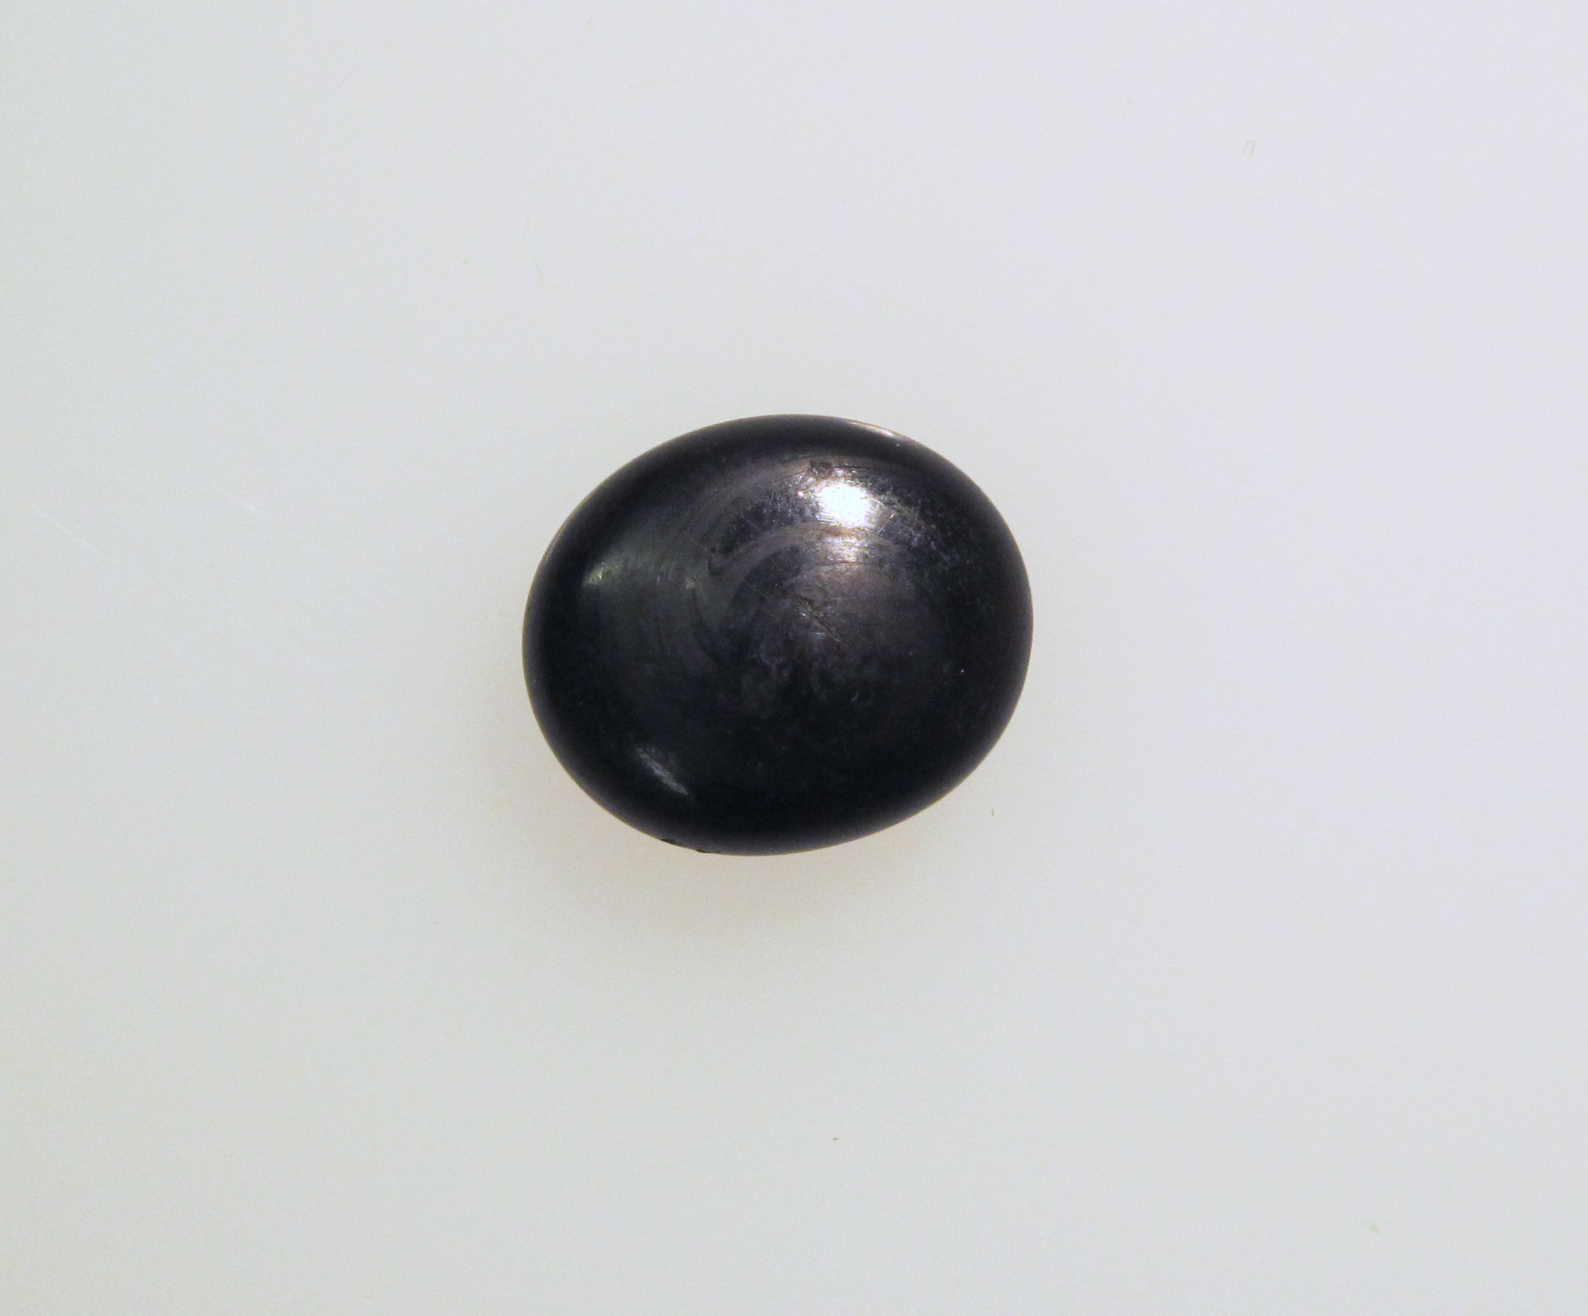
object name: pinhead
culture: roman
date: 100 BCE-500 CE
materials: glass